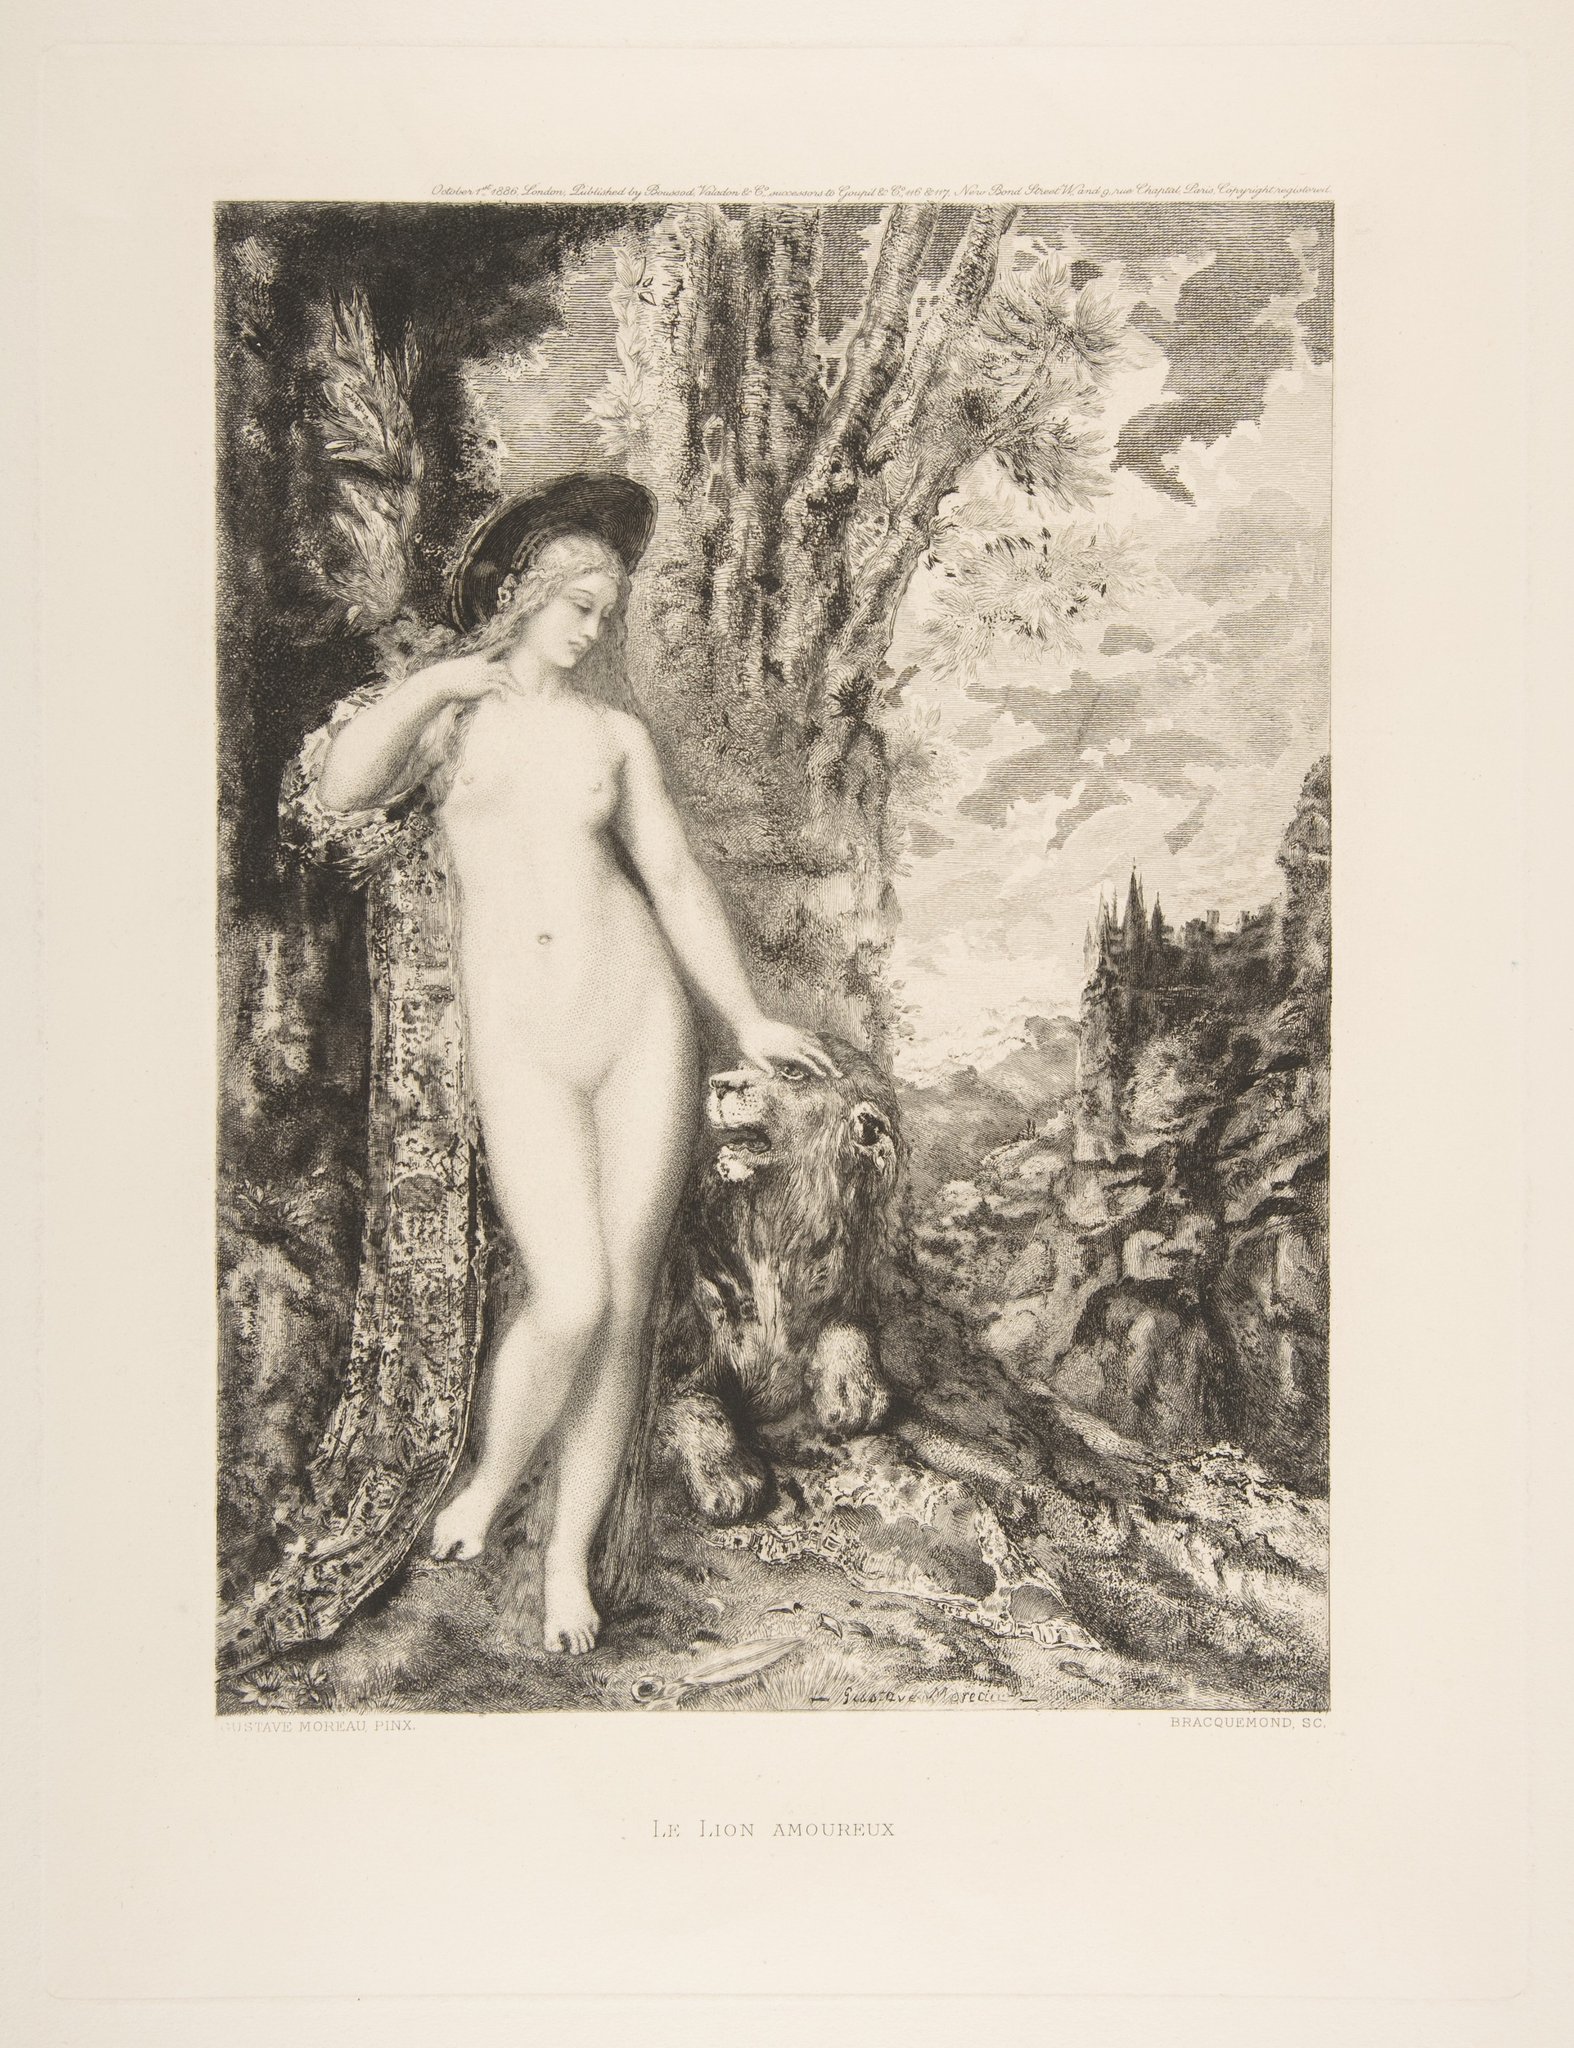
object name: print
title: Le Lion amoureux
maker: félix bracquemond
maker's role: artist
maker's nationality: french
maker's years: 1833-1914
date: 1886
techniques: etching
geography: france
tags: female nudes,lions,trees